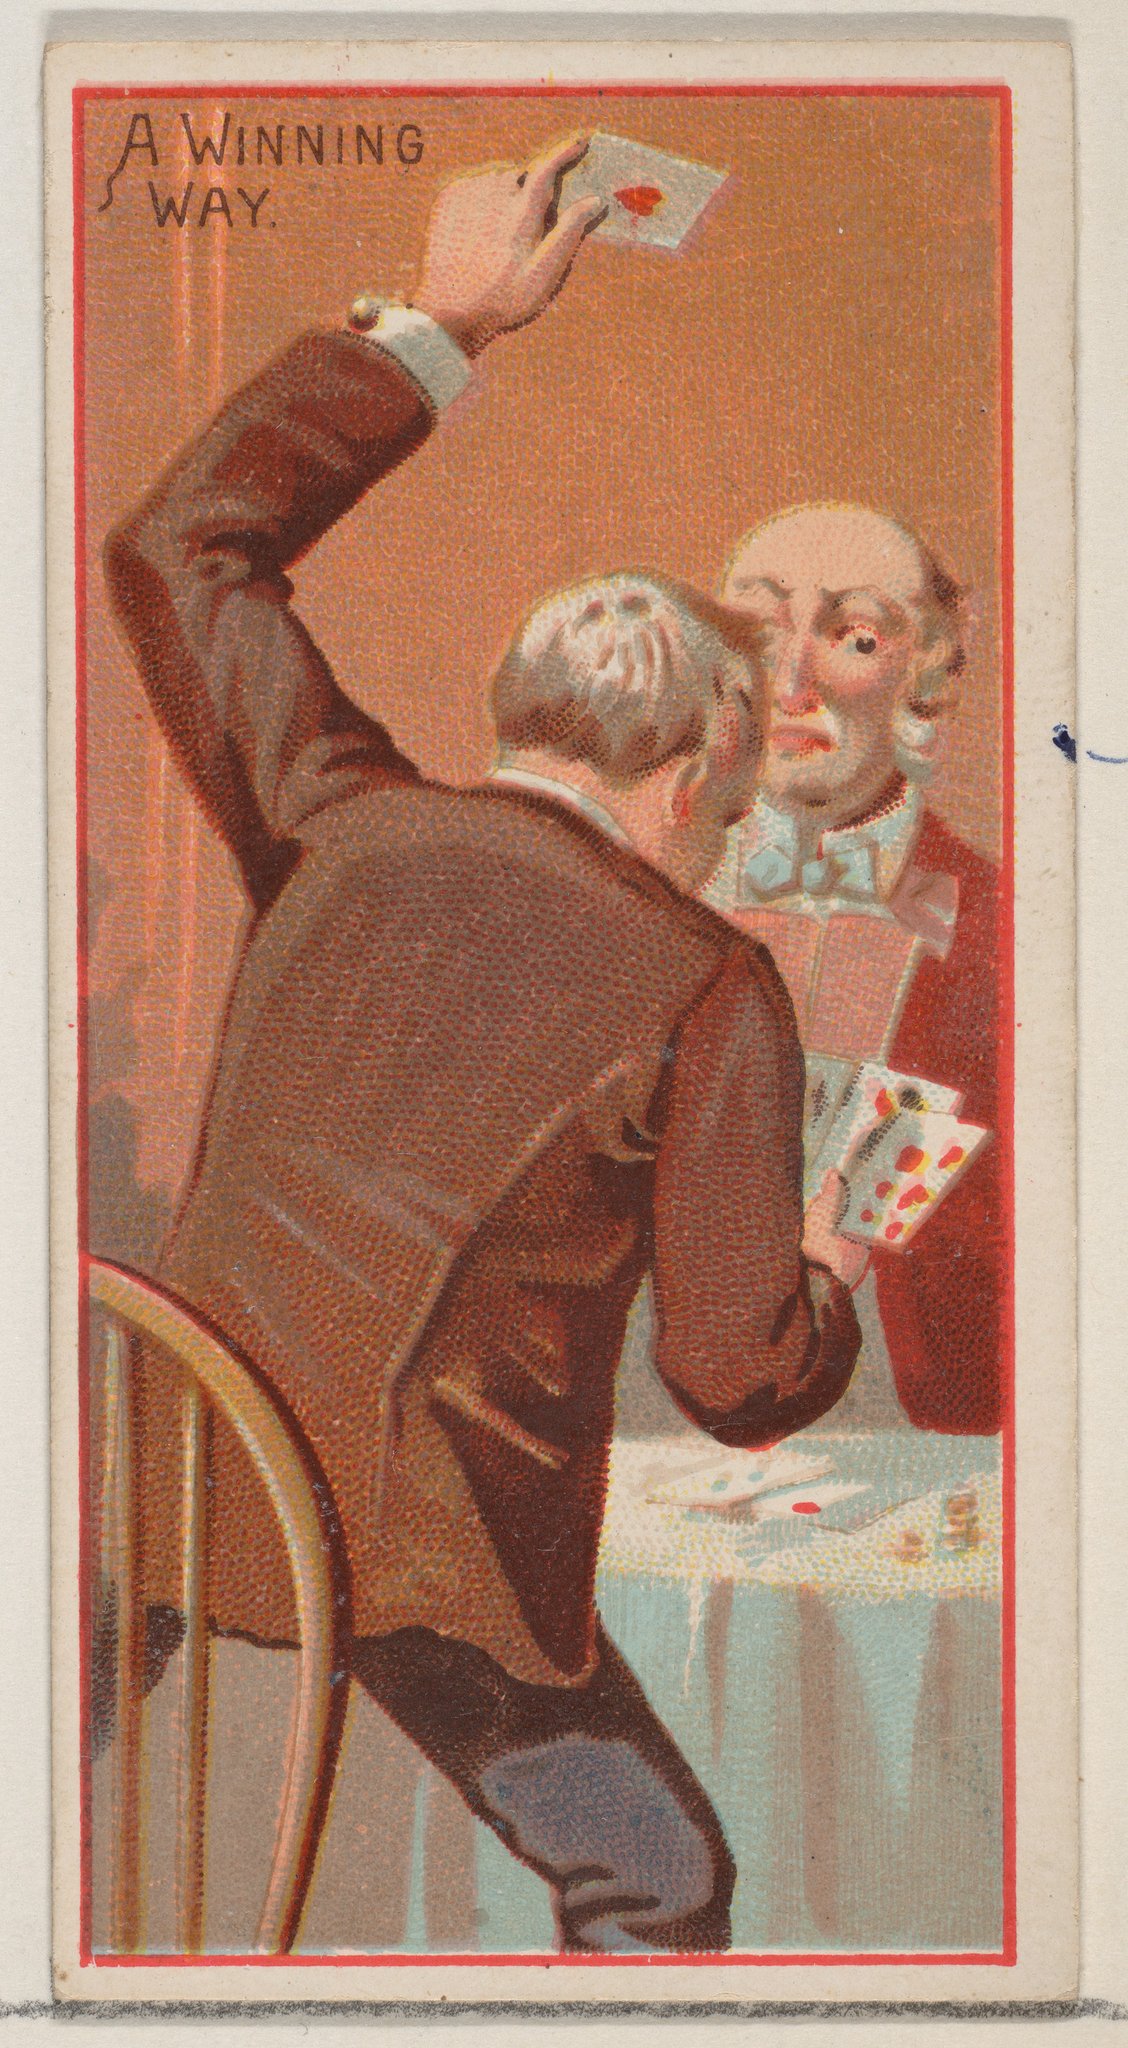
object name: print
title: A Winning Way, from the Jokes series (N87) for Duke brand cigarettes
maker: w. duke, sons & co.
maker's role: publisher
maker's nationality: american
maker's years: 1870-1920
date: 1890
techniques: color lithograph